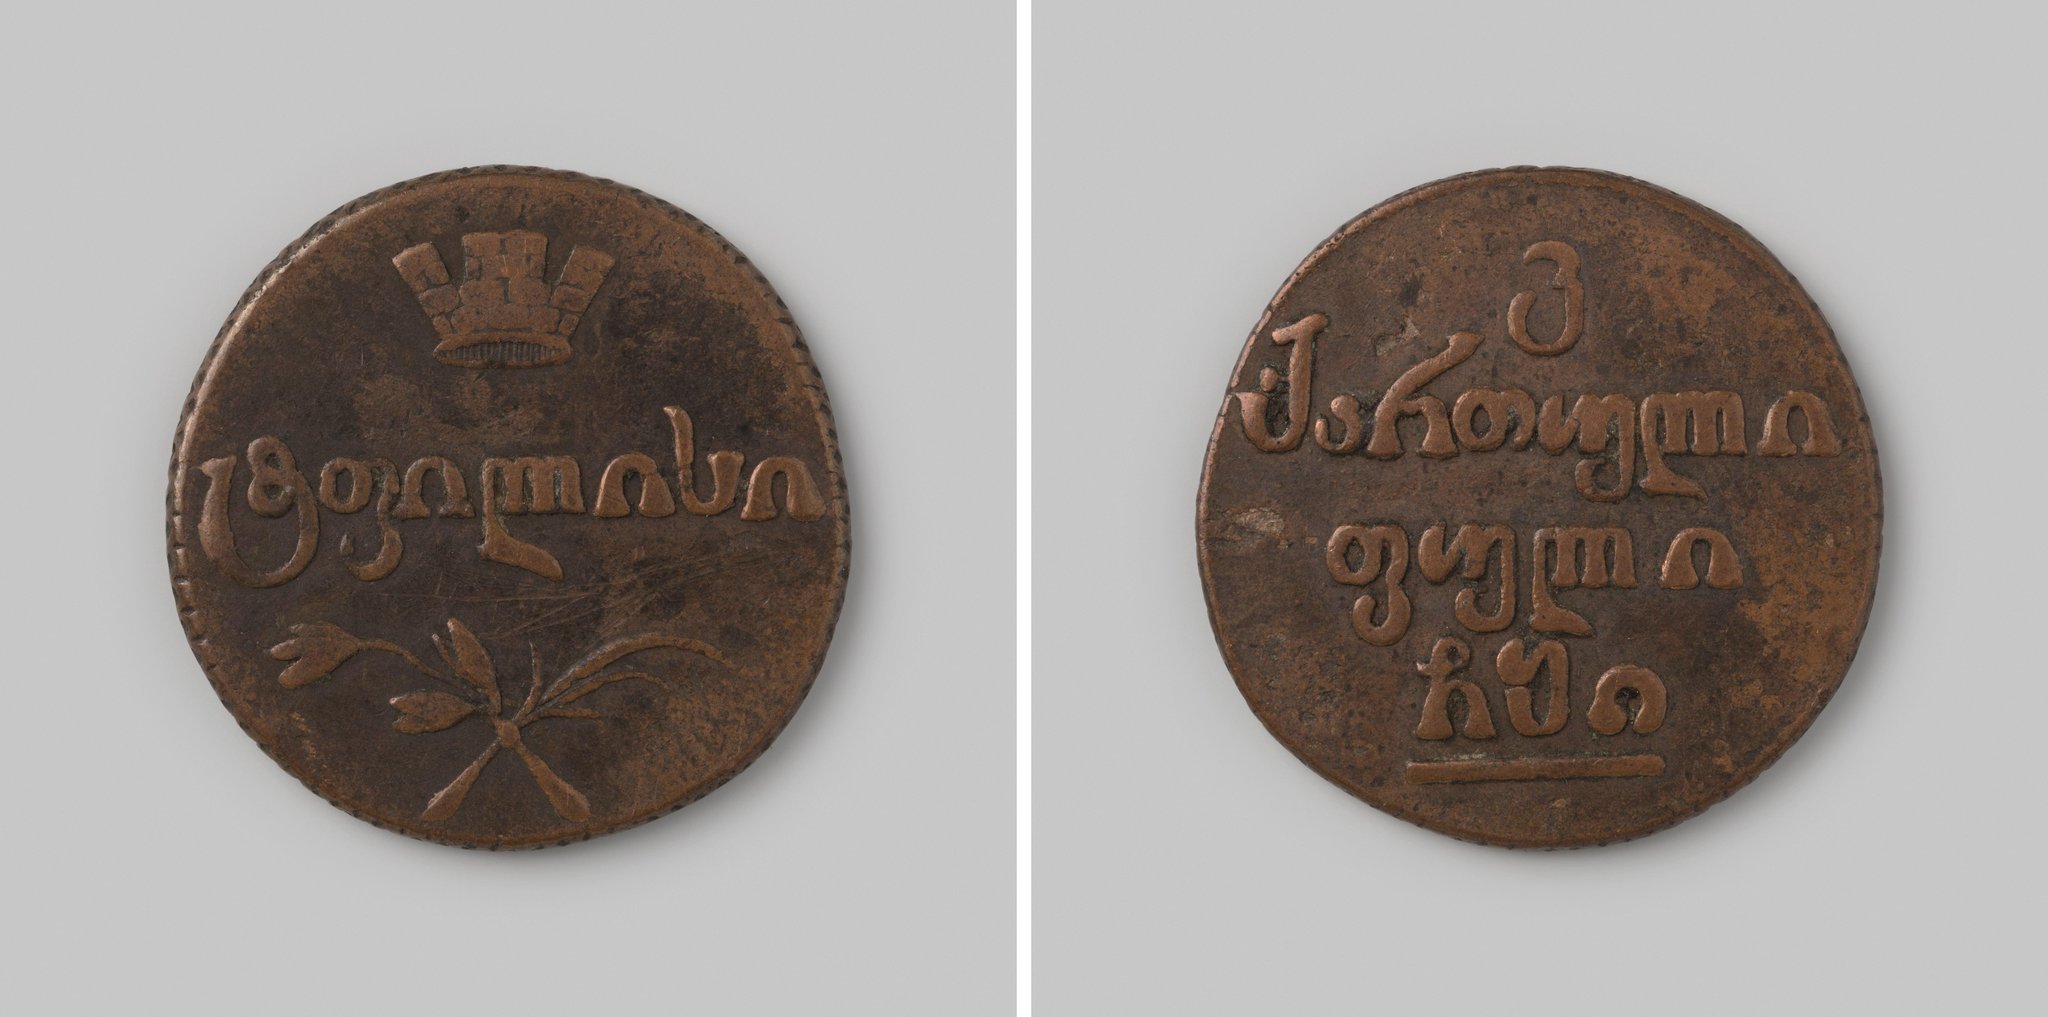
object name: coin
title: 4 poeli of 2 kopeken uit Georgië van tsaar Alexander I, 1810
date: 1810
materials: copper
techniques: striking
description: Koperen munt. Voorzijde: aanduiding in Georgisch schrift. Daarboven een kroon en daaronder twee gekruiste takken. Keerzijde: in drie regels de waarde-aanduiding in Georgisch schrift, waaronder jaartal in het Georgisch. Kabelrand.